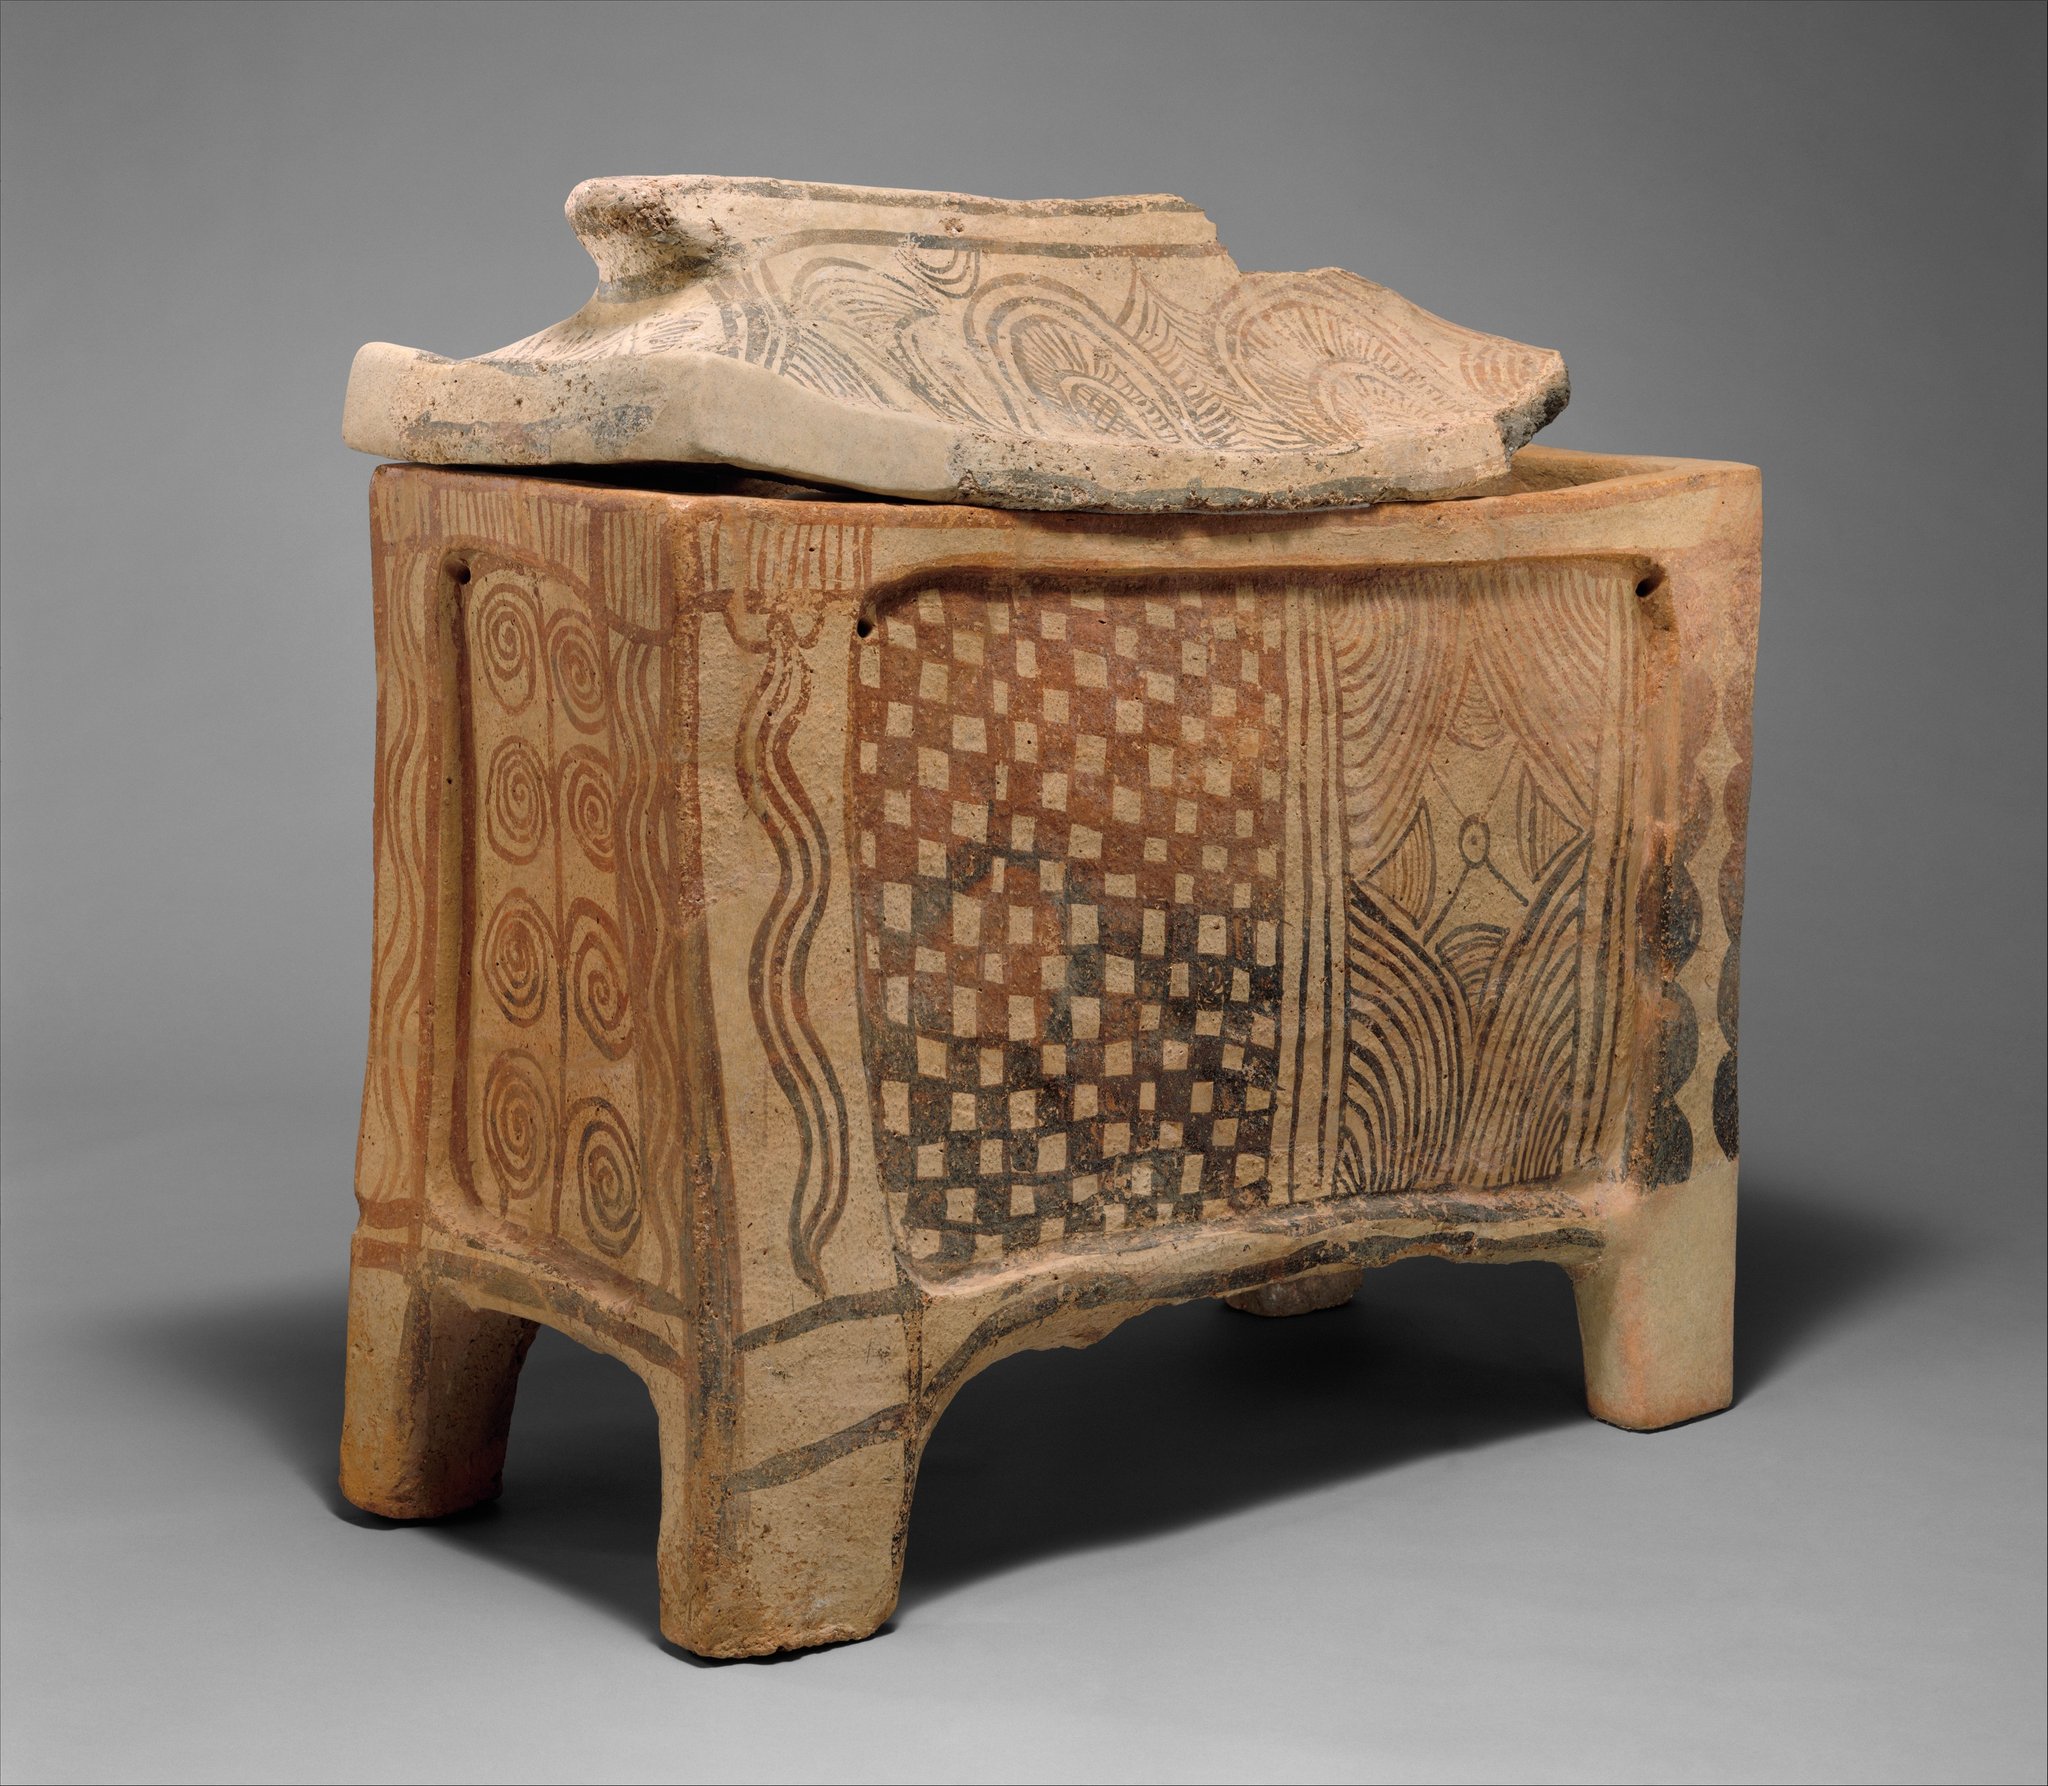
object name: larnax with lid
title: Terracotta larnax (chest-shaped coffin)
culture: minoan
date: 1267-1235 BCE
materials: terracotta